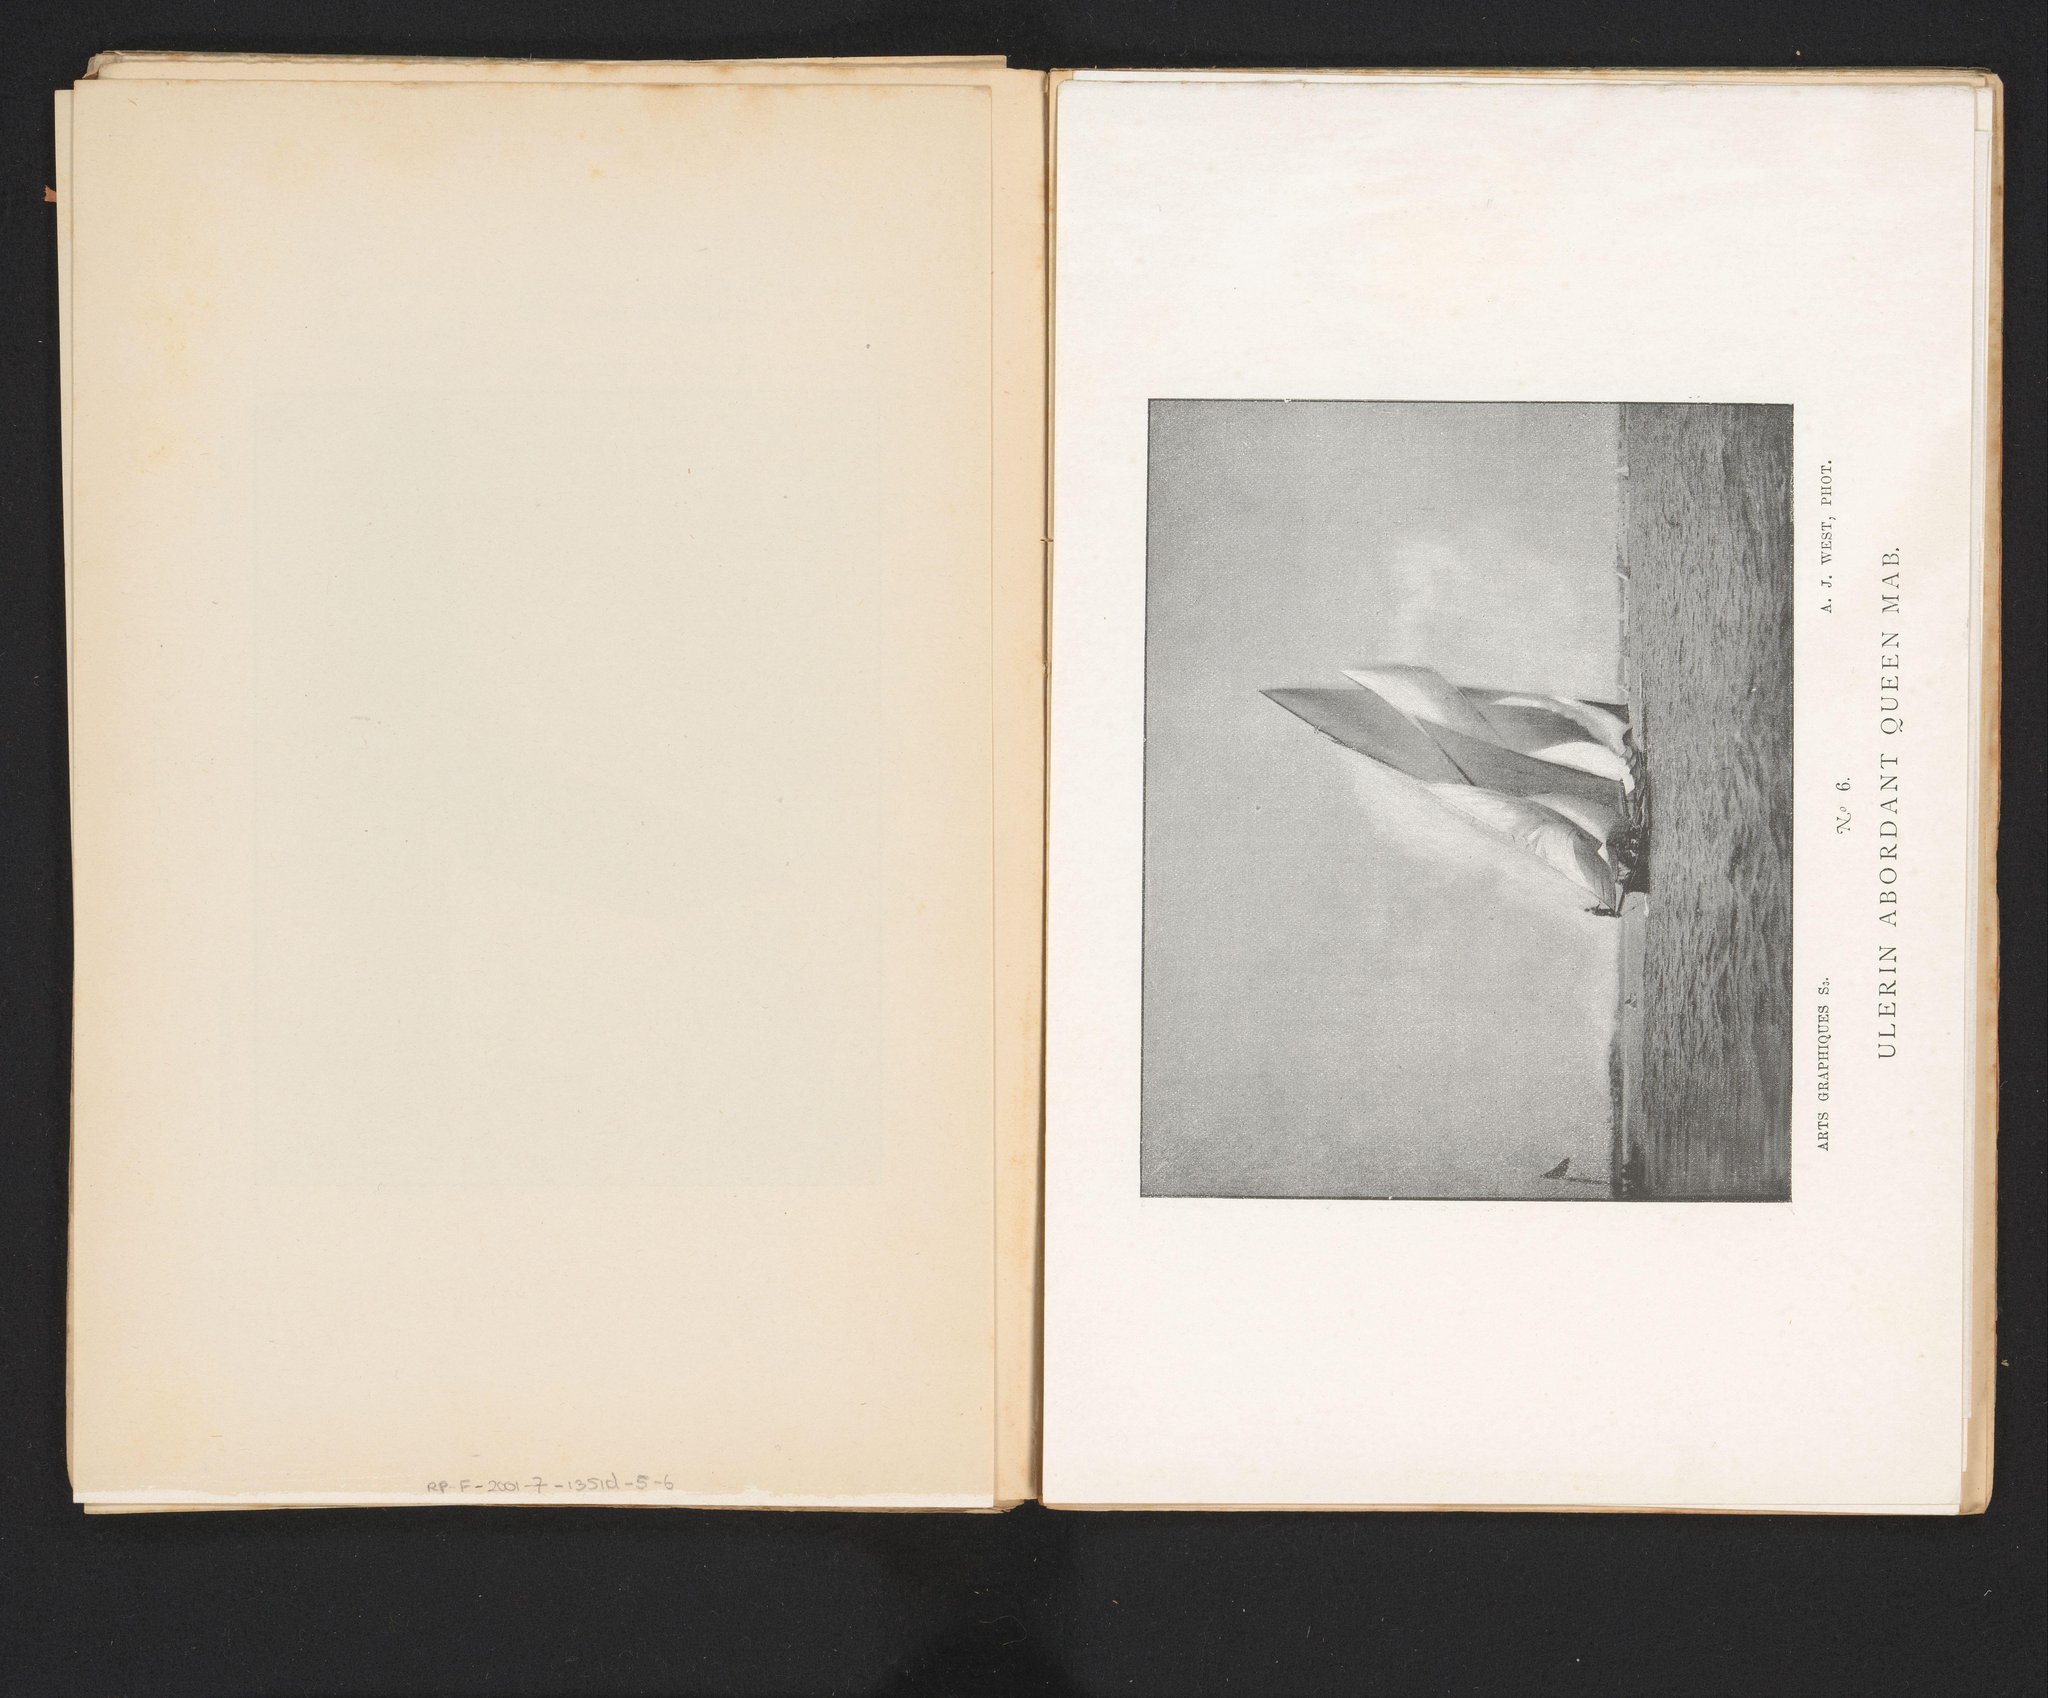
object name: photomechanical print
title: Zeilschip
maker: a.j. west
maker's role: fotograaf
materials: paper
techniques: collo-autotype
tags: sailing-ship, sailing-boat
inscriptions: number: ‘No 6.’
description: Prent op plaat los in boek tussen pagina 254 en 255.